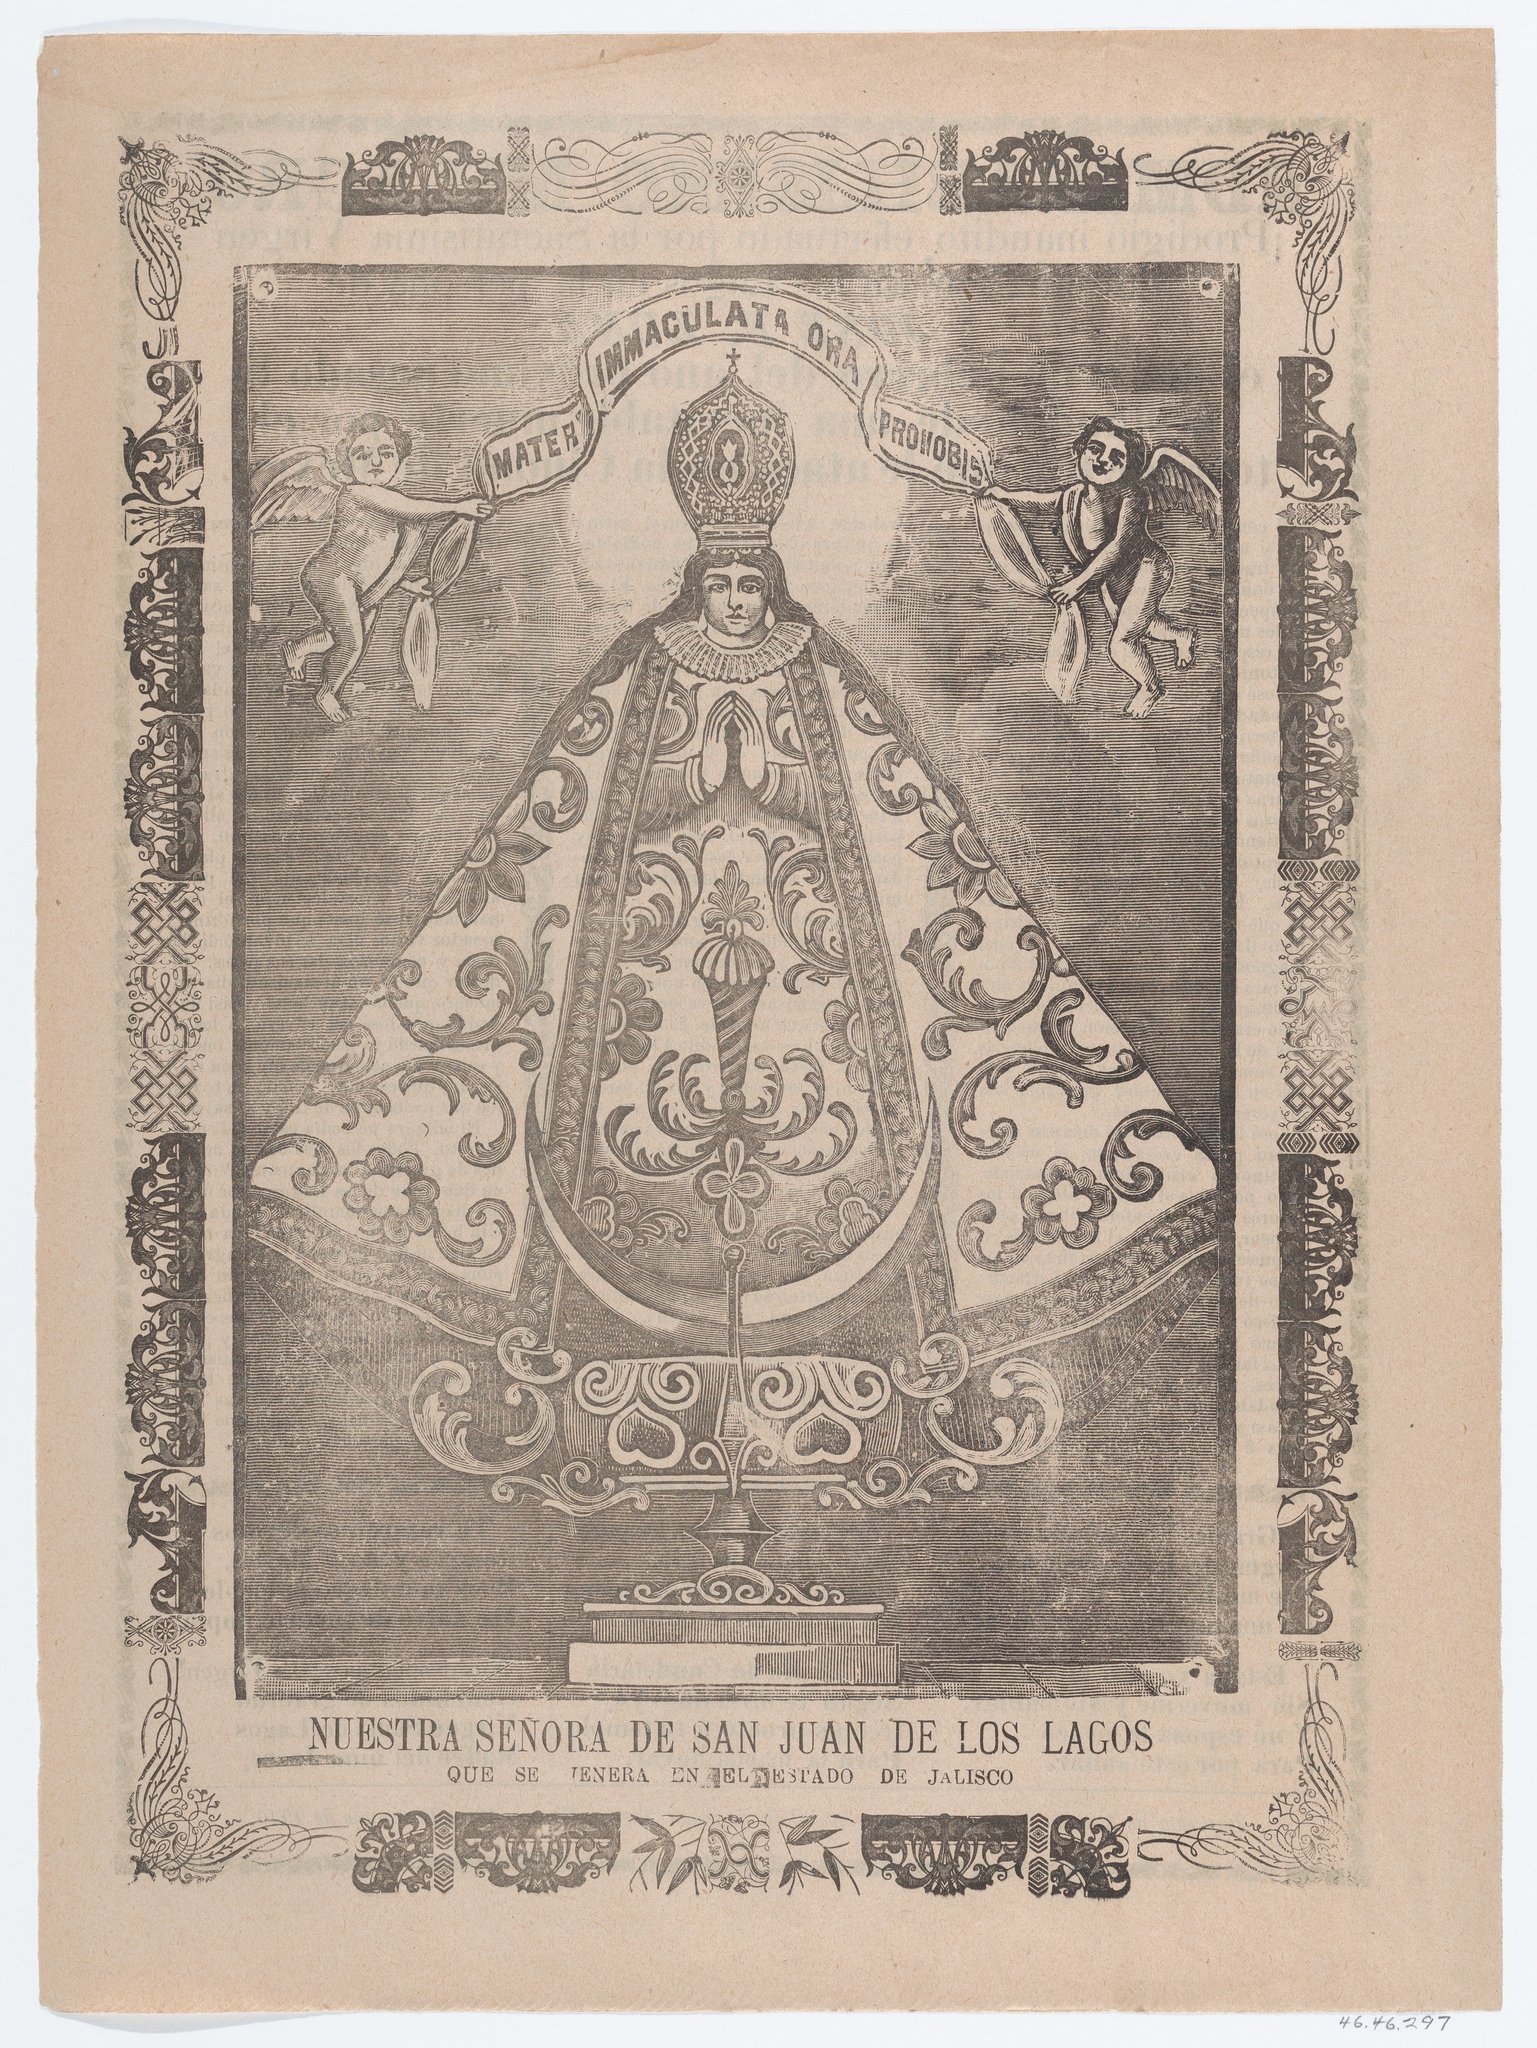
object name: print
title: Broadsheet with image of Our Lady of San Juan de los Lagos, venerated in Jalisco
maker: josé guadalupe posada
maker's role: artist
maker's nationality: mexican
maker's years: 1852-1913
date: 1910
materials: paper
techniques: letterpress, lithograph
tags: angels,virgin mary